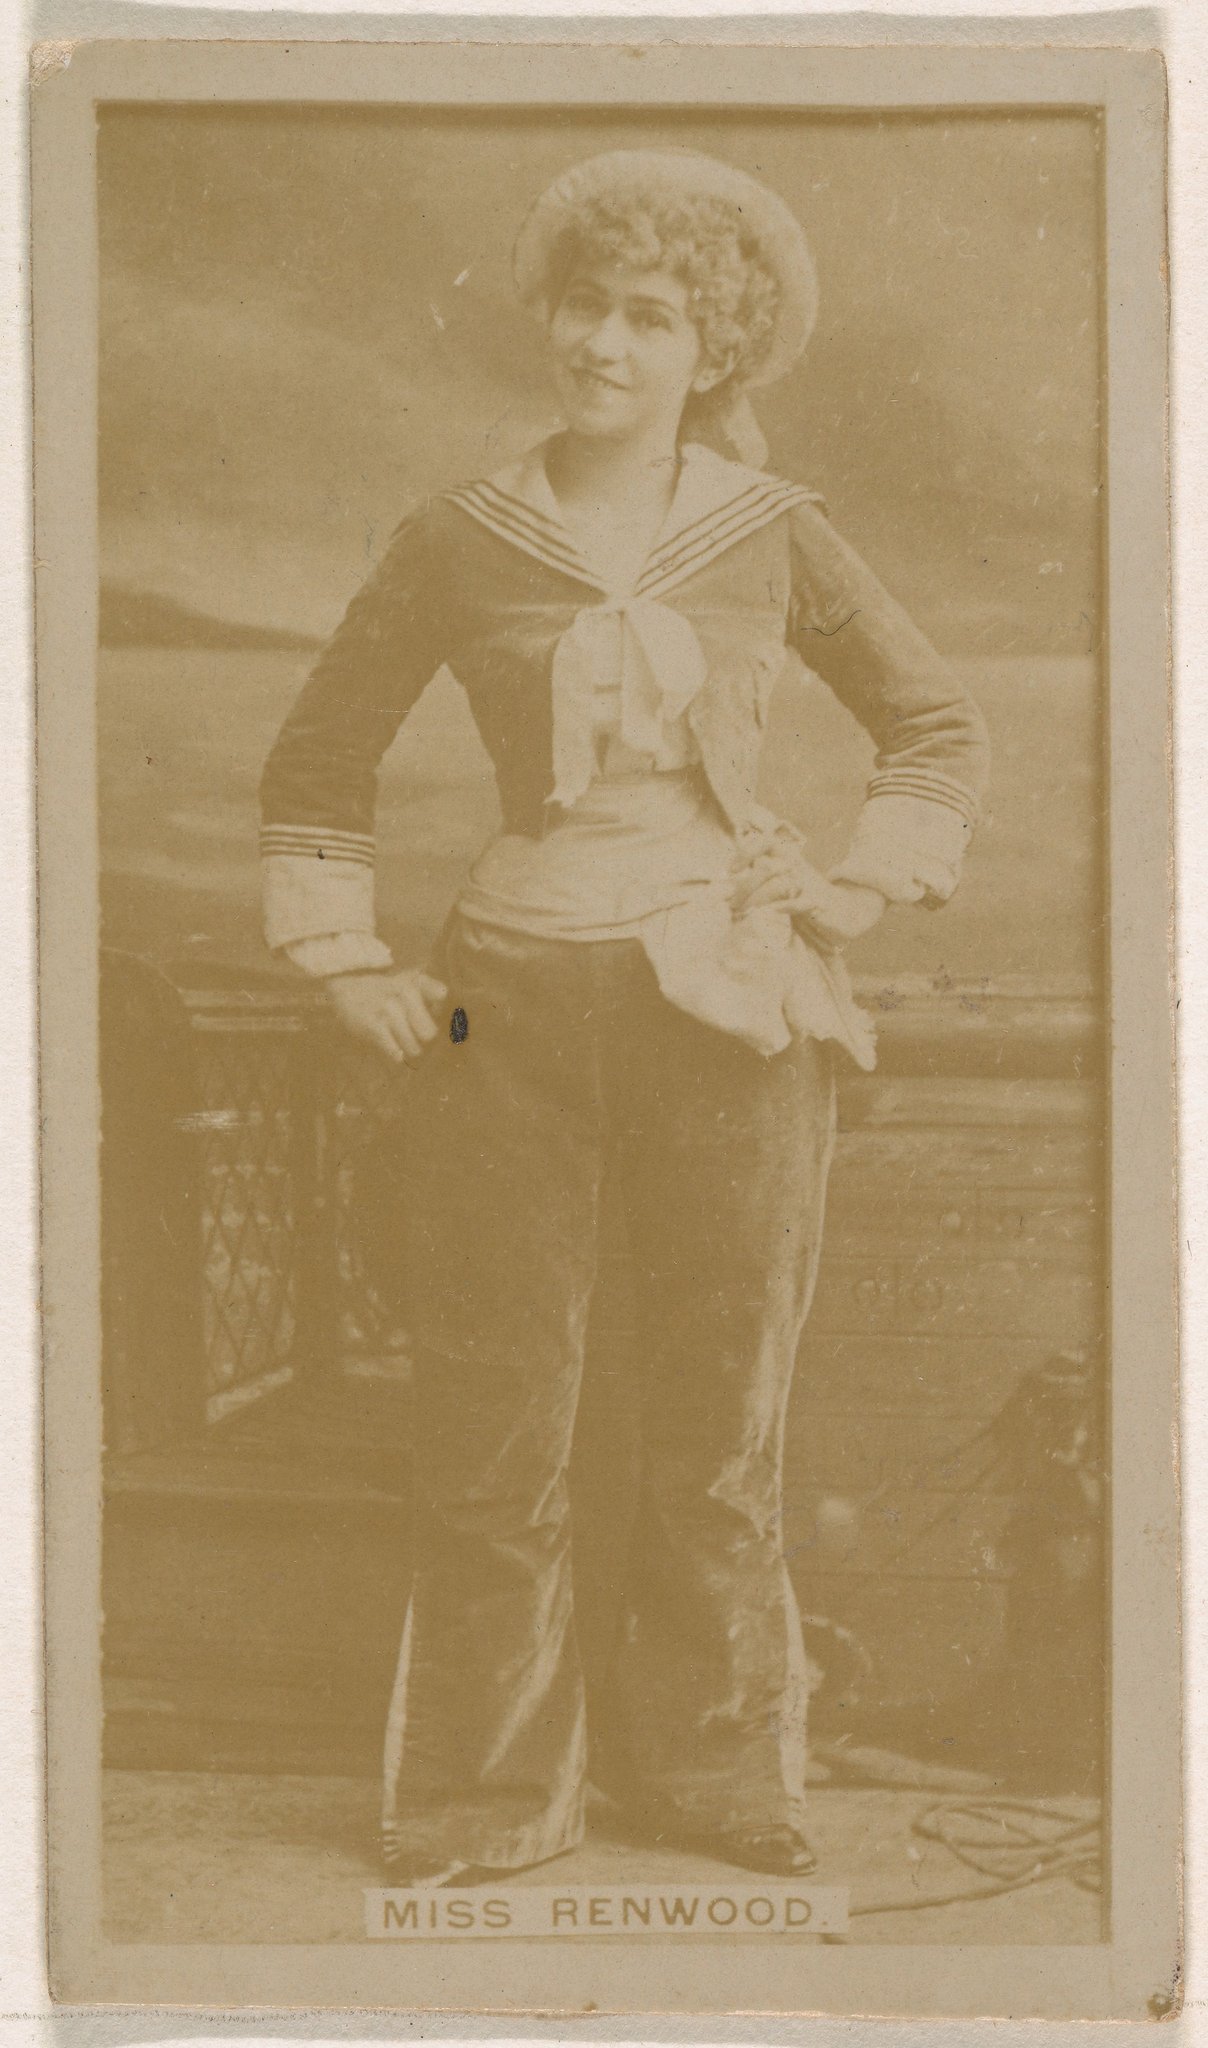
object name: photograph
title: Miss Renwood, from the Actresses series (N245) issued by Kinney Brothers to promote Sweet Caporal Cigarettes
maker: kinney brothers tobacco company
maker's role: publisher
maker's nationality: american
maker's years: 1869-2011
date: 1890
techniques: albumen silver print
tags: portraits,women,actresses